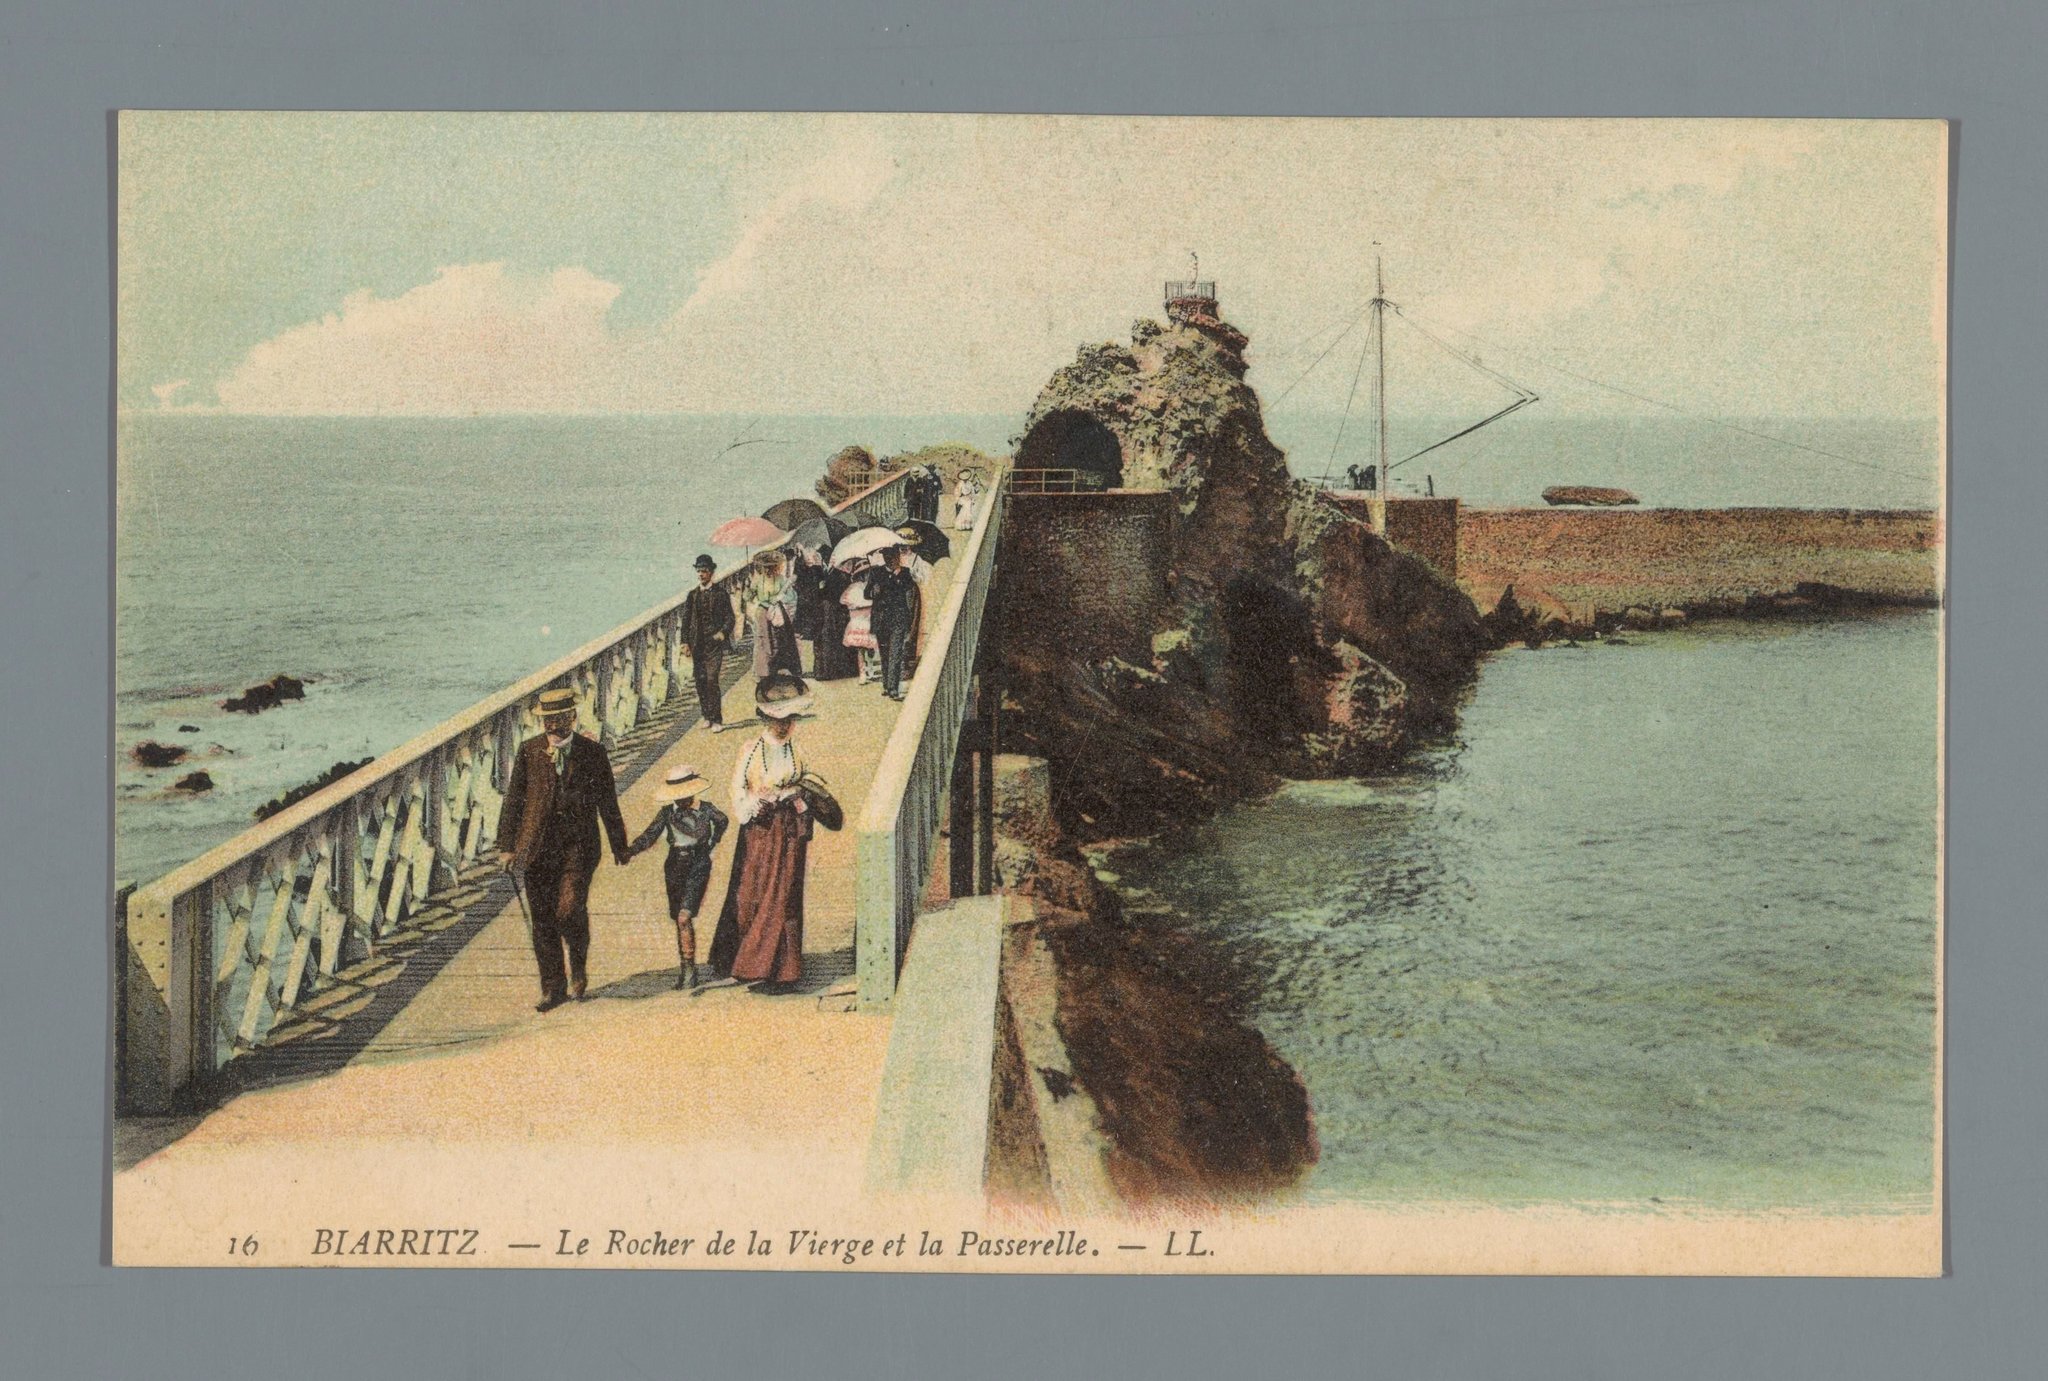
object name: ansichtkaart, prentbriefkaart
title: Biarritz - Le Rocher de la Vierge et la Passerelle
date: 1890-1920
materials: paper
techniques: photograph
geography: rocher de la vierge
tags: rocky coast, bridge, sea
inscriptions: number: ‘16’